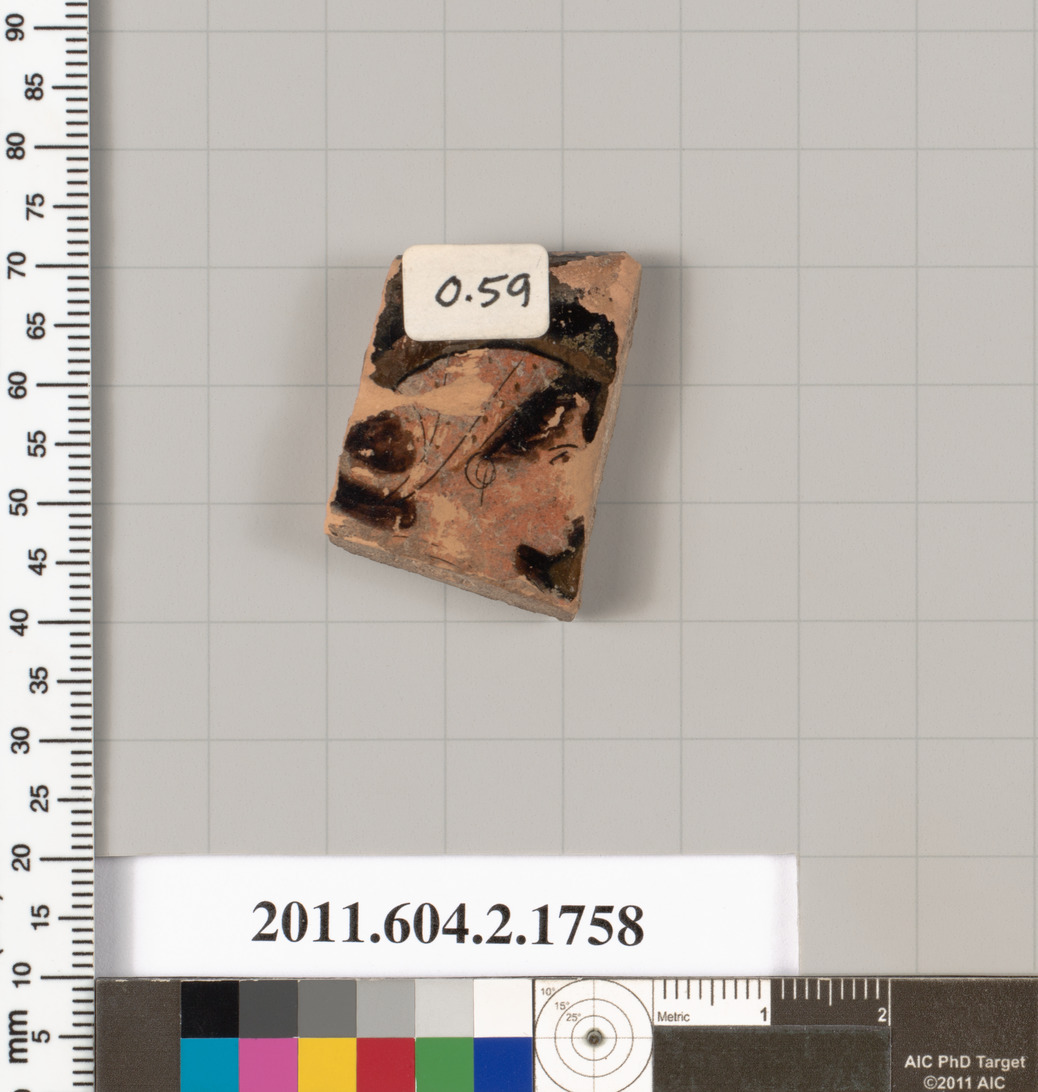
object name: skyphos fragment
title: Terracotta rim fragment of a skyphos (deep drinking cup)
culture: greek, attic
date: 460-450 BCE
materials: terracotta